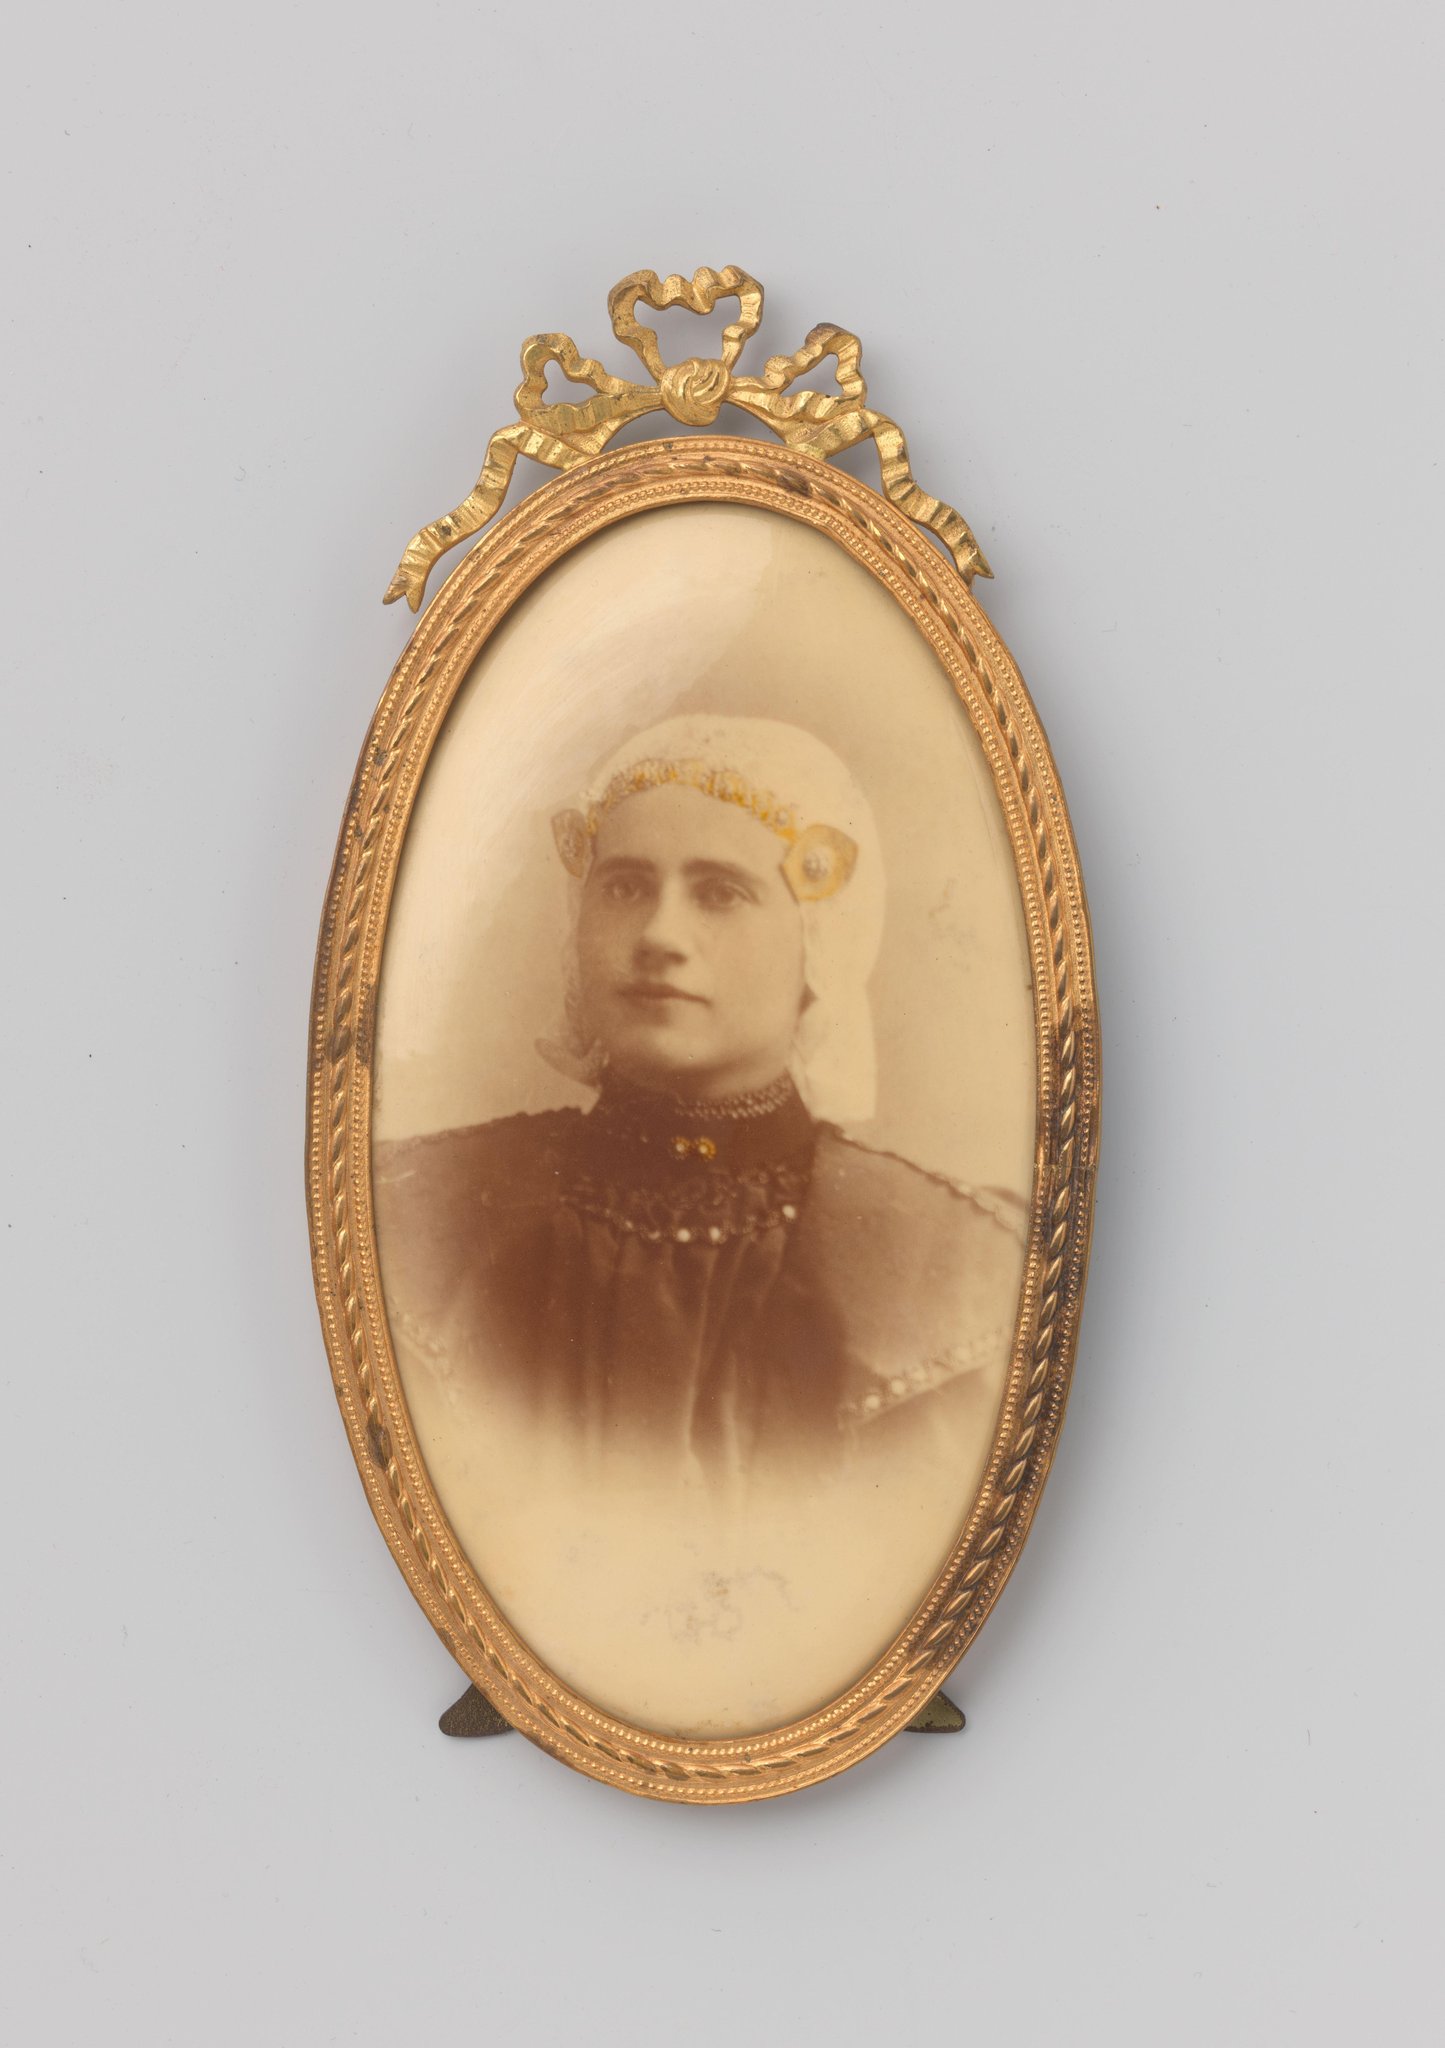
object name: frame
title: Portret van onbekende vrouw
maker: Anonymous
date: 1880-1900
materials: metal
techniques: photobutton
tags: adult woman, anonymous historical person portrayed